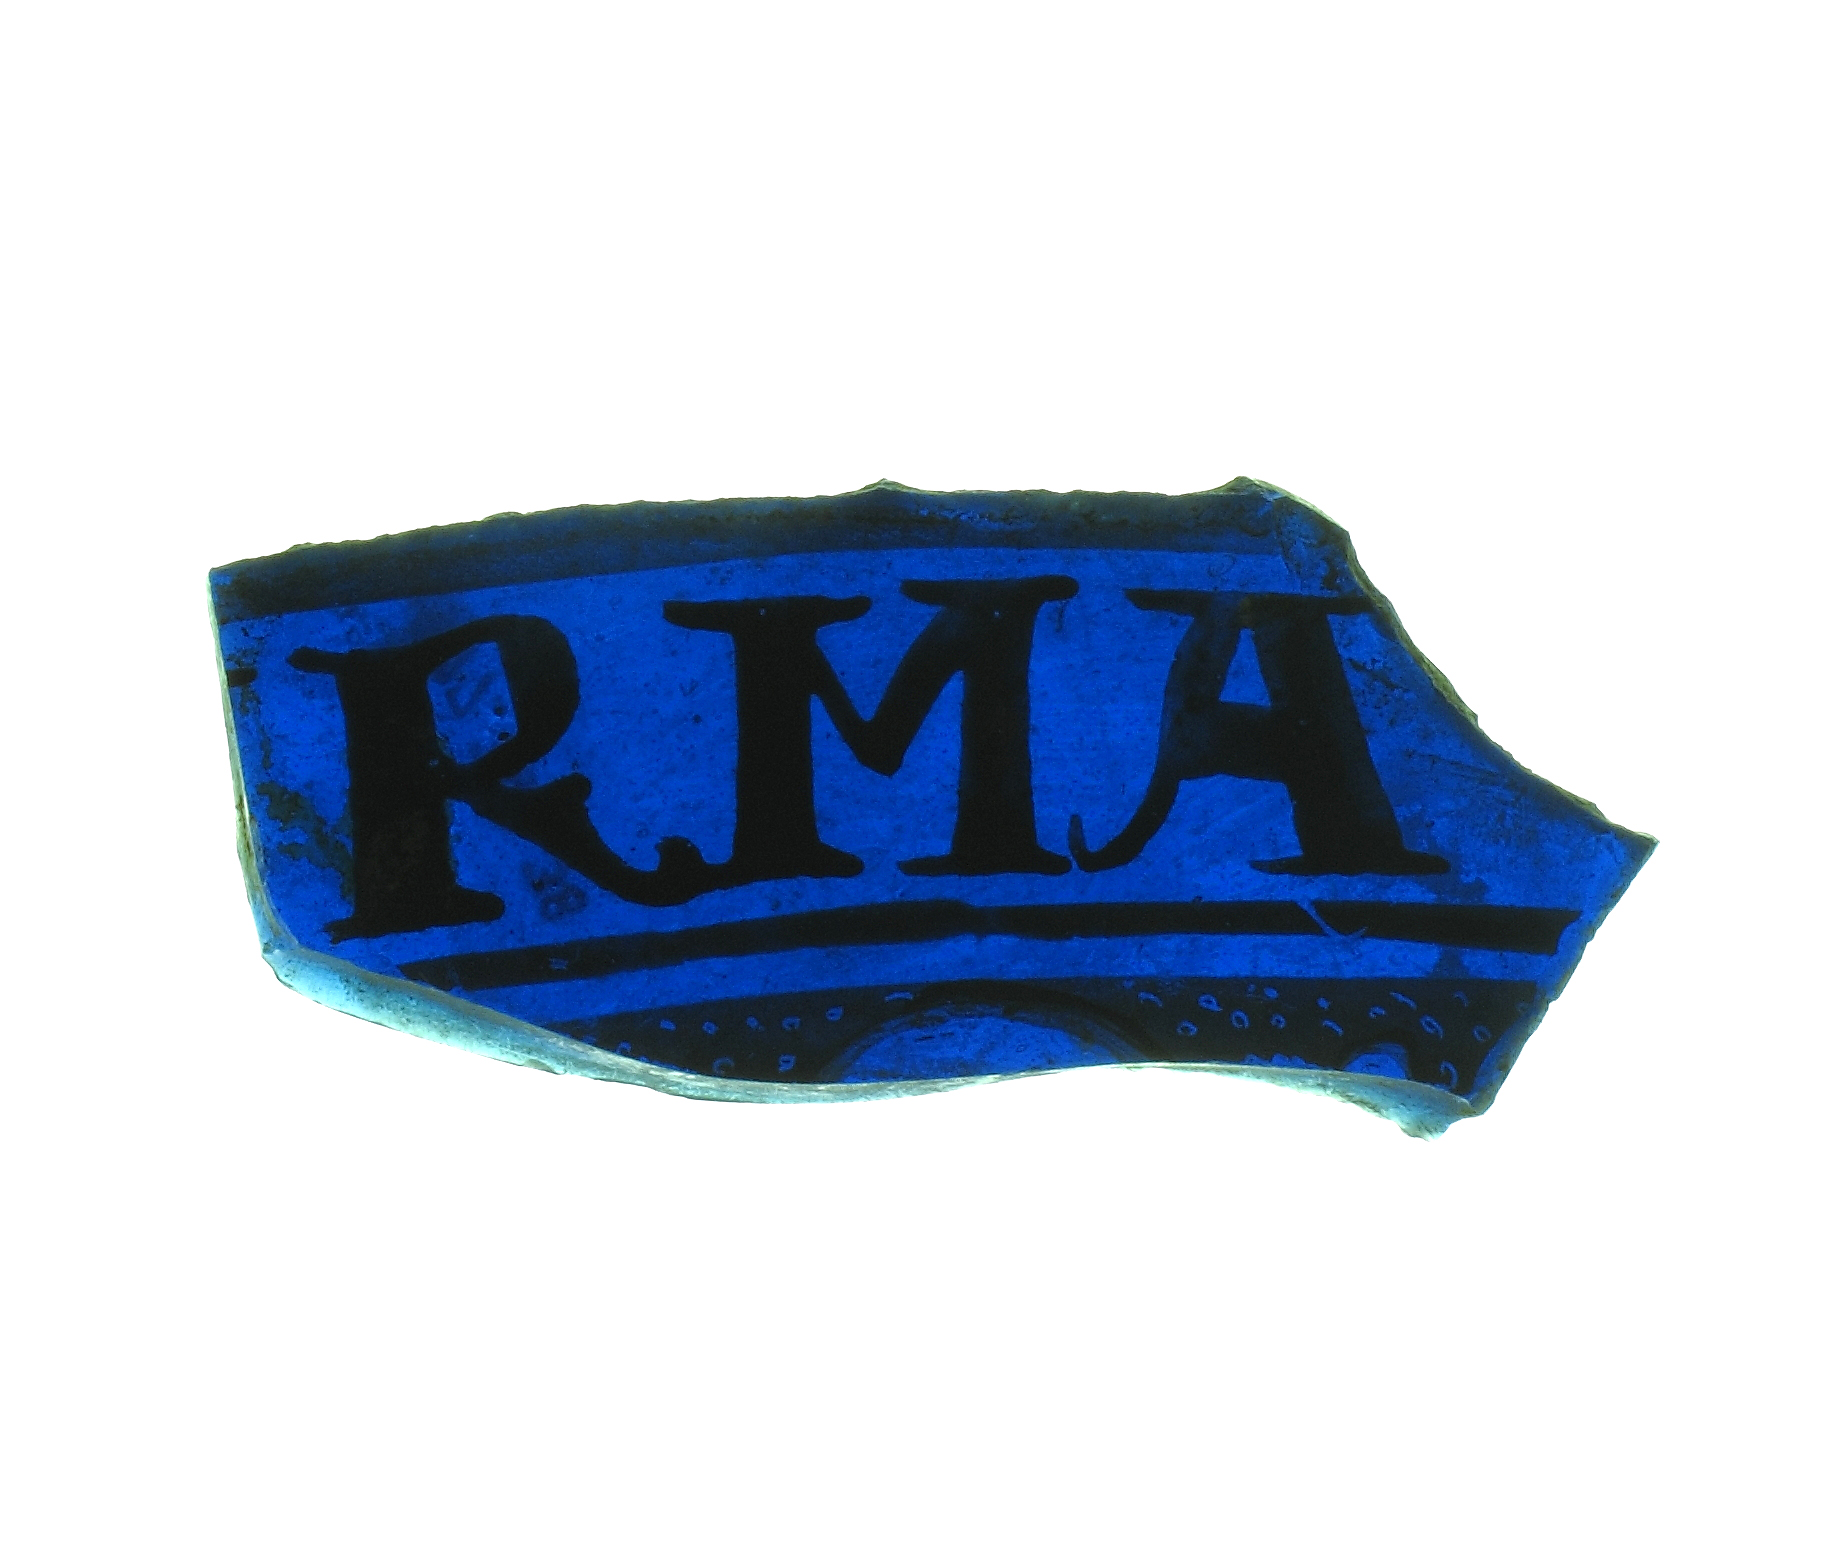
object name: fragment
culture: french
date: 1101-1400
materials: glass, metal, paint